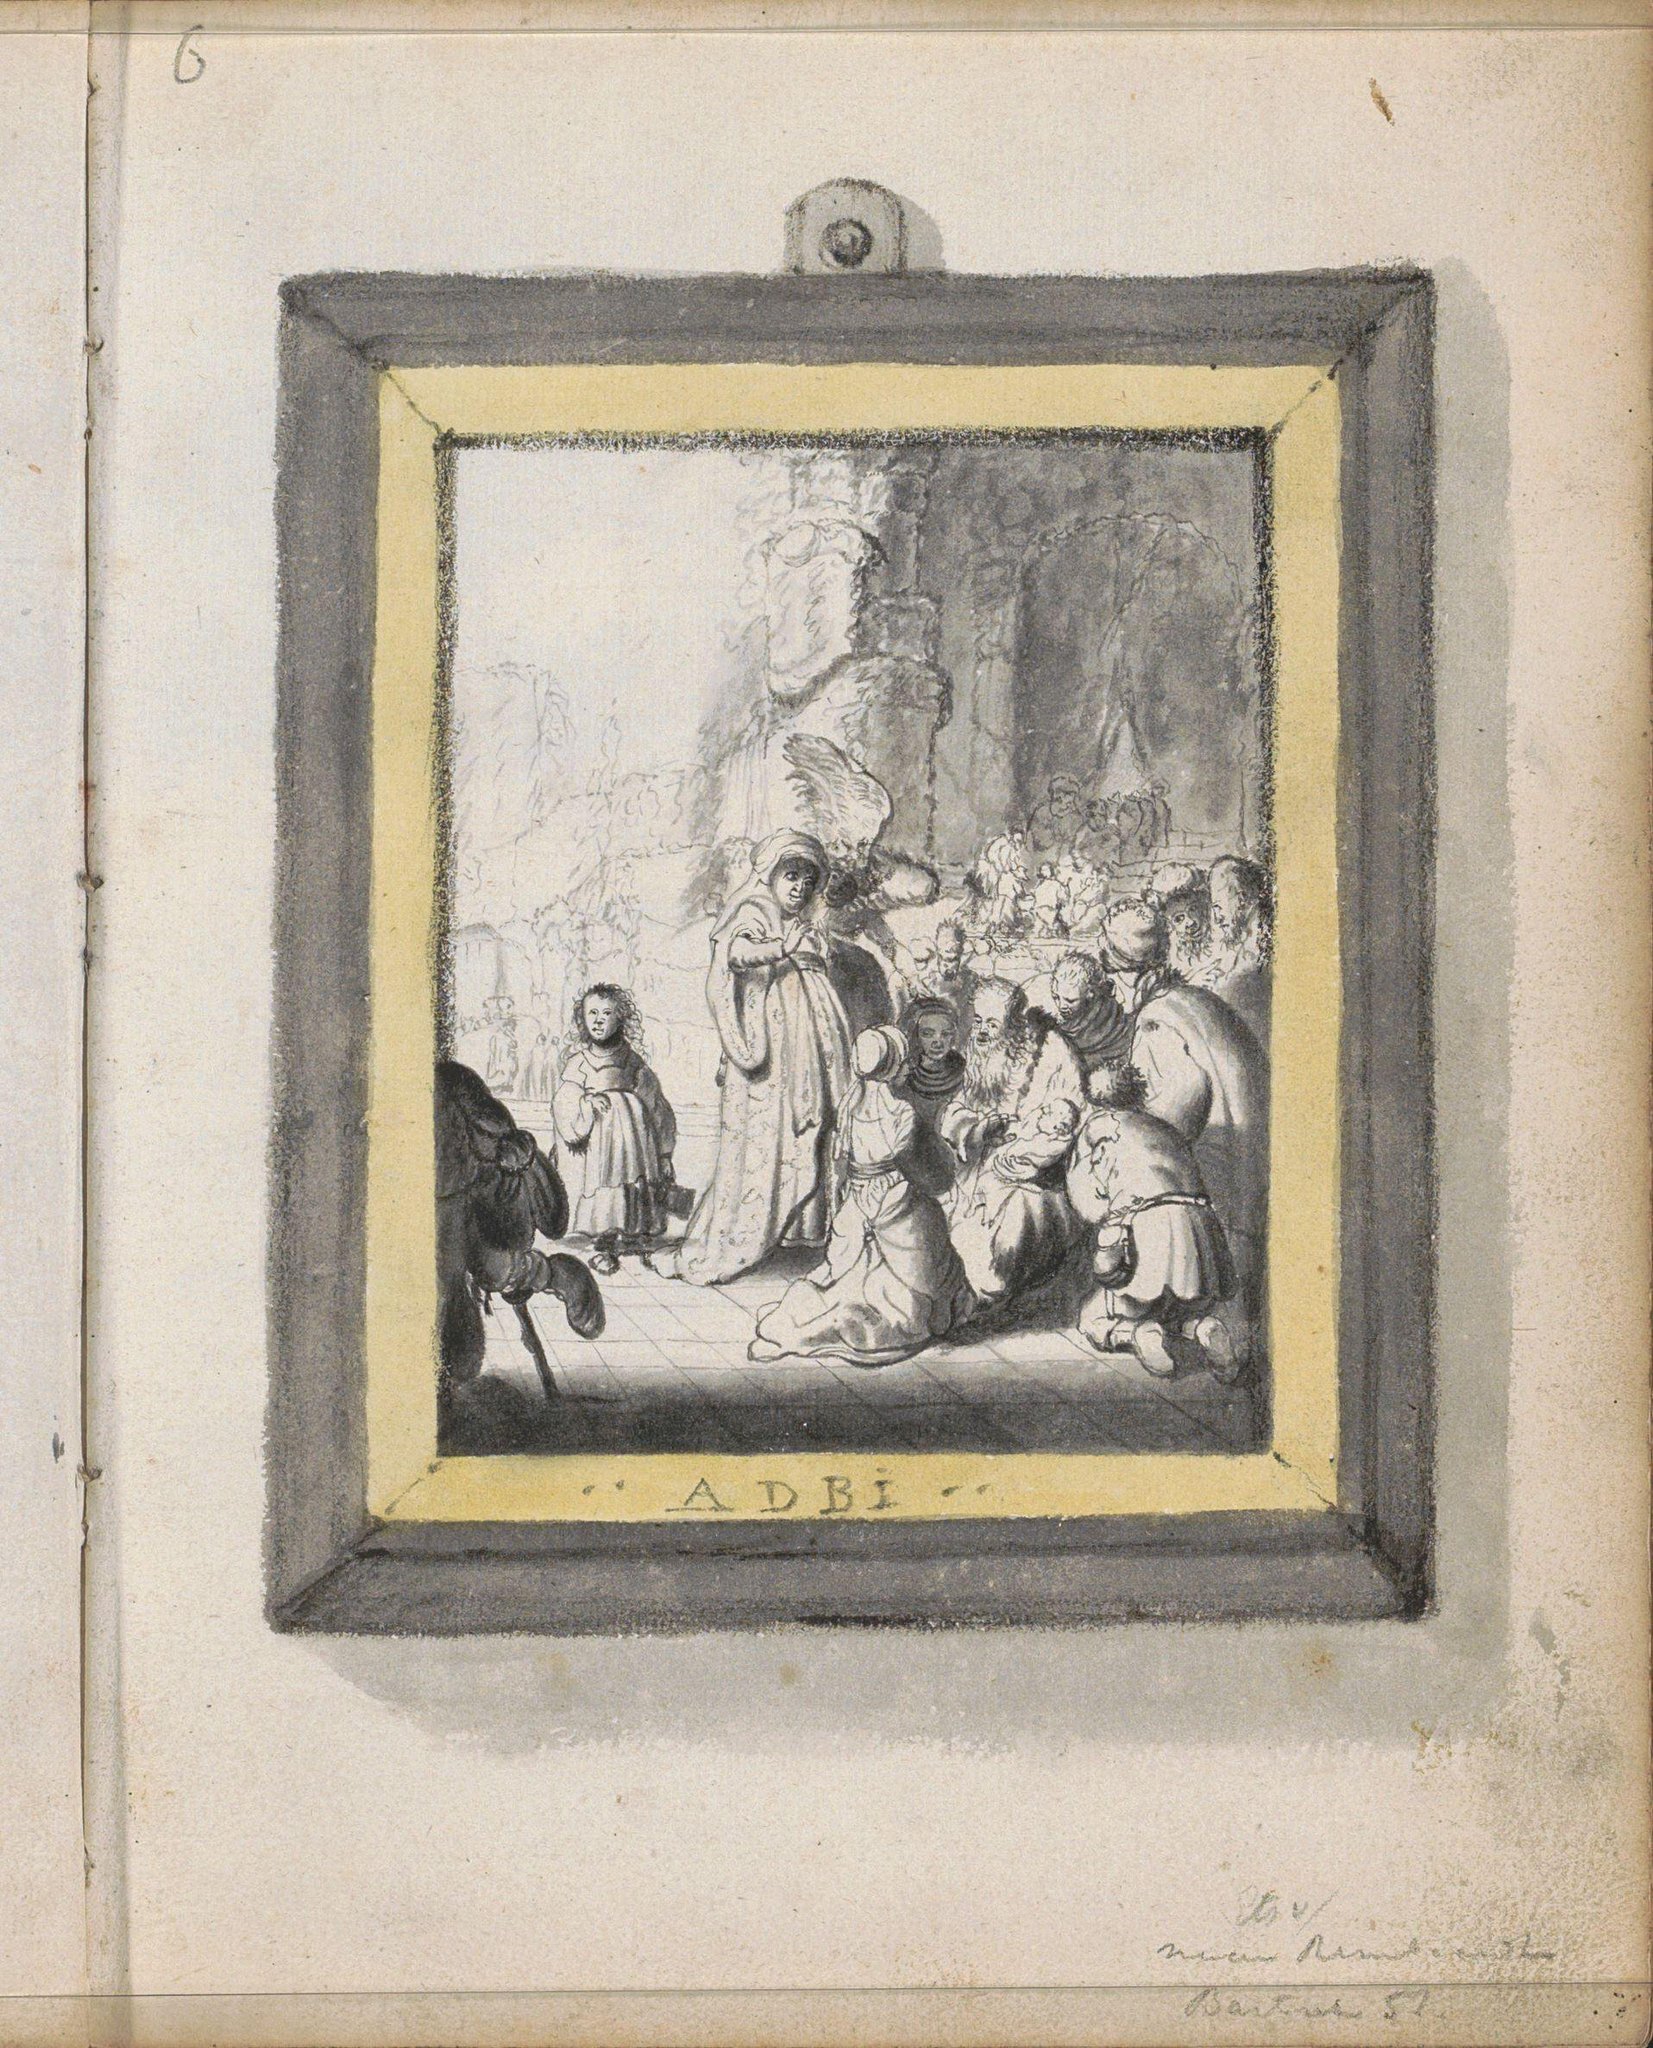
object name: sketchbook leaf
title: Presentatie van Christus in de tempel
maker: abraham du belije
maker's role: draughtsman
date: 1666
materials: chalk, ink, paper, watercolor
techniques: brush, pen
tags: frame of painting, etc., presentation of the christ-child in the temple, usually simeon (and anna) present (luke 2:22-39)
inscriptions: annotation: ‘naar ets v Rembrandt/ Bartsch 51’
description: In een tempelruimte zit Simeon met het Christuskind in de armen. Tekening van een prent in een lijst. Blad 6 recto uit een schetsboek met 49 bladen.